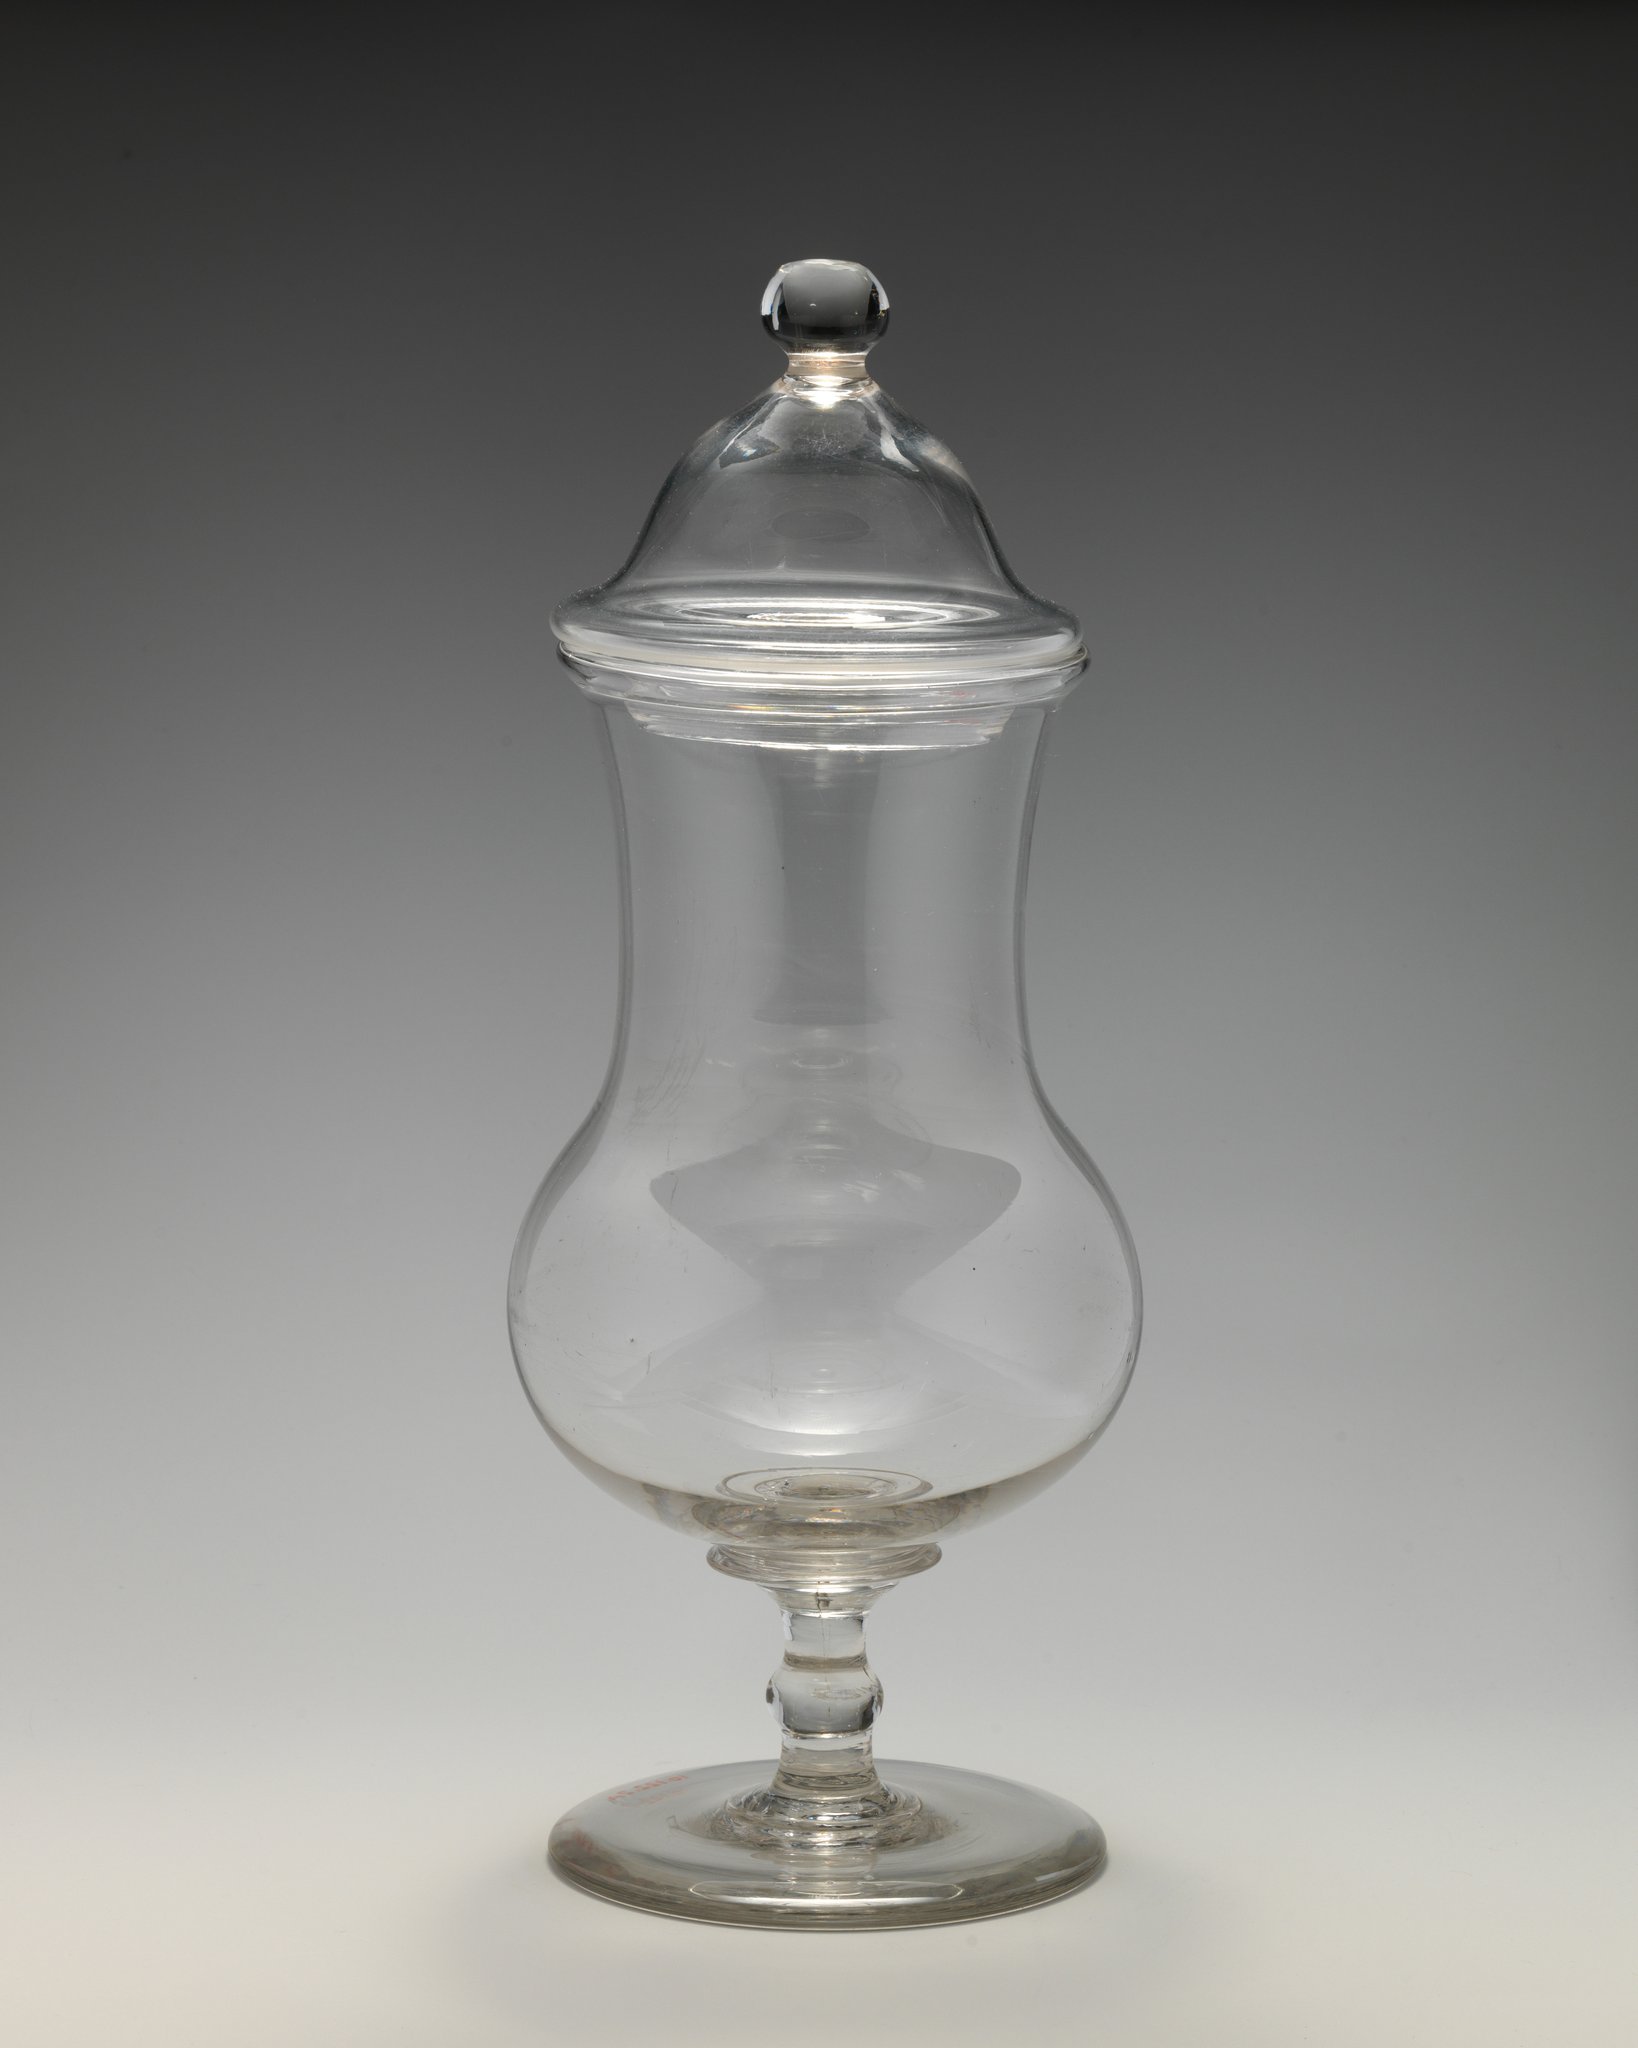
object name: jar with cover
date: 1701-1800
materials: glass